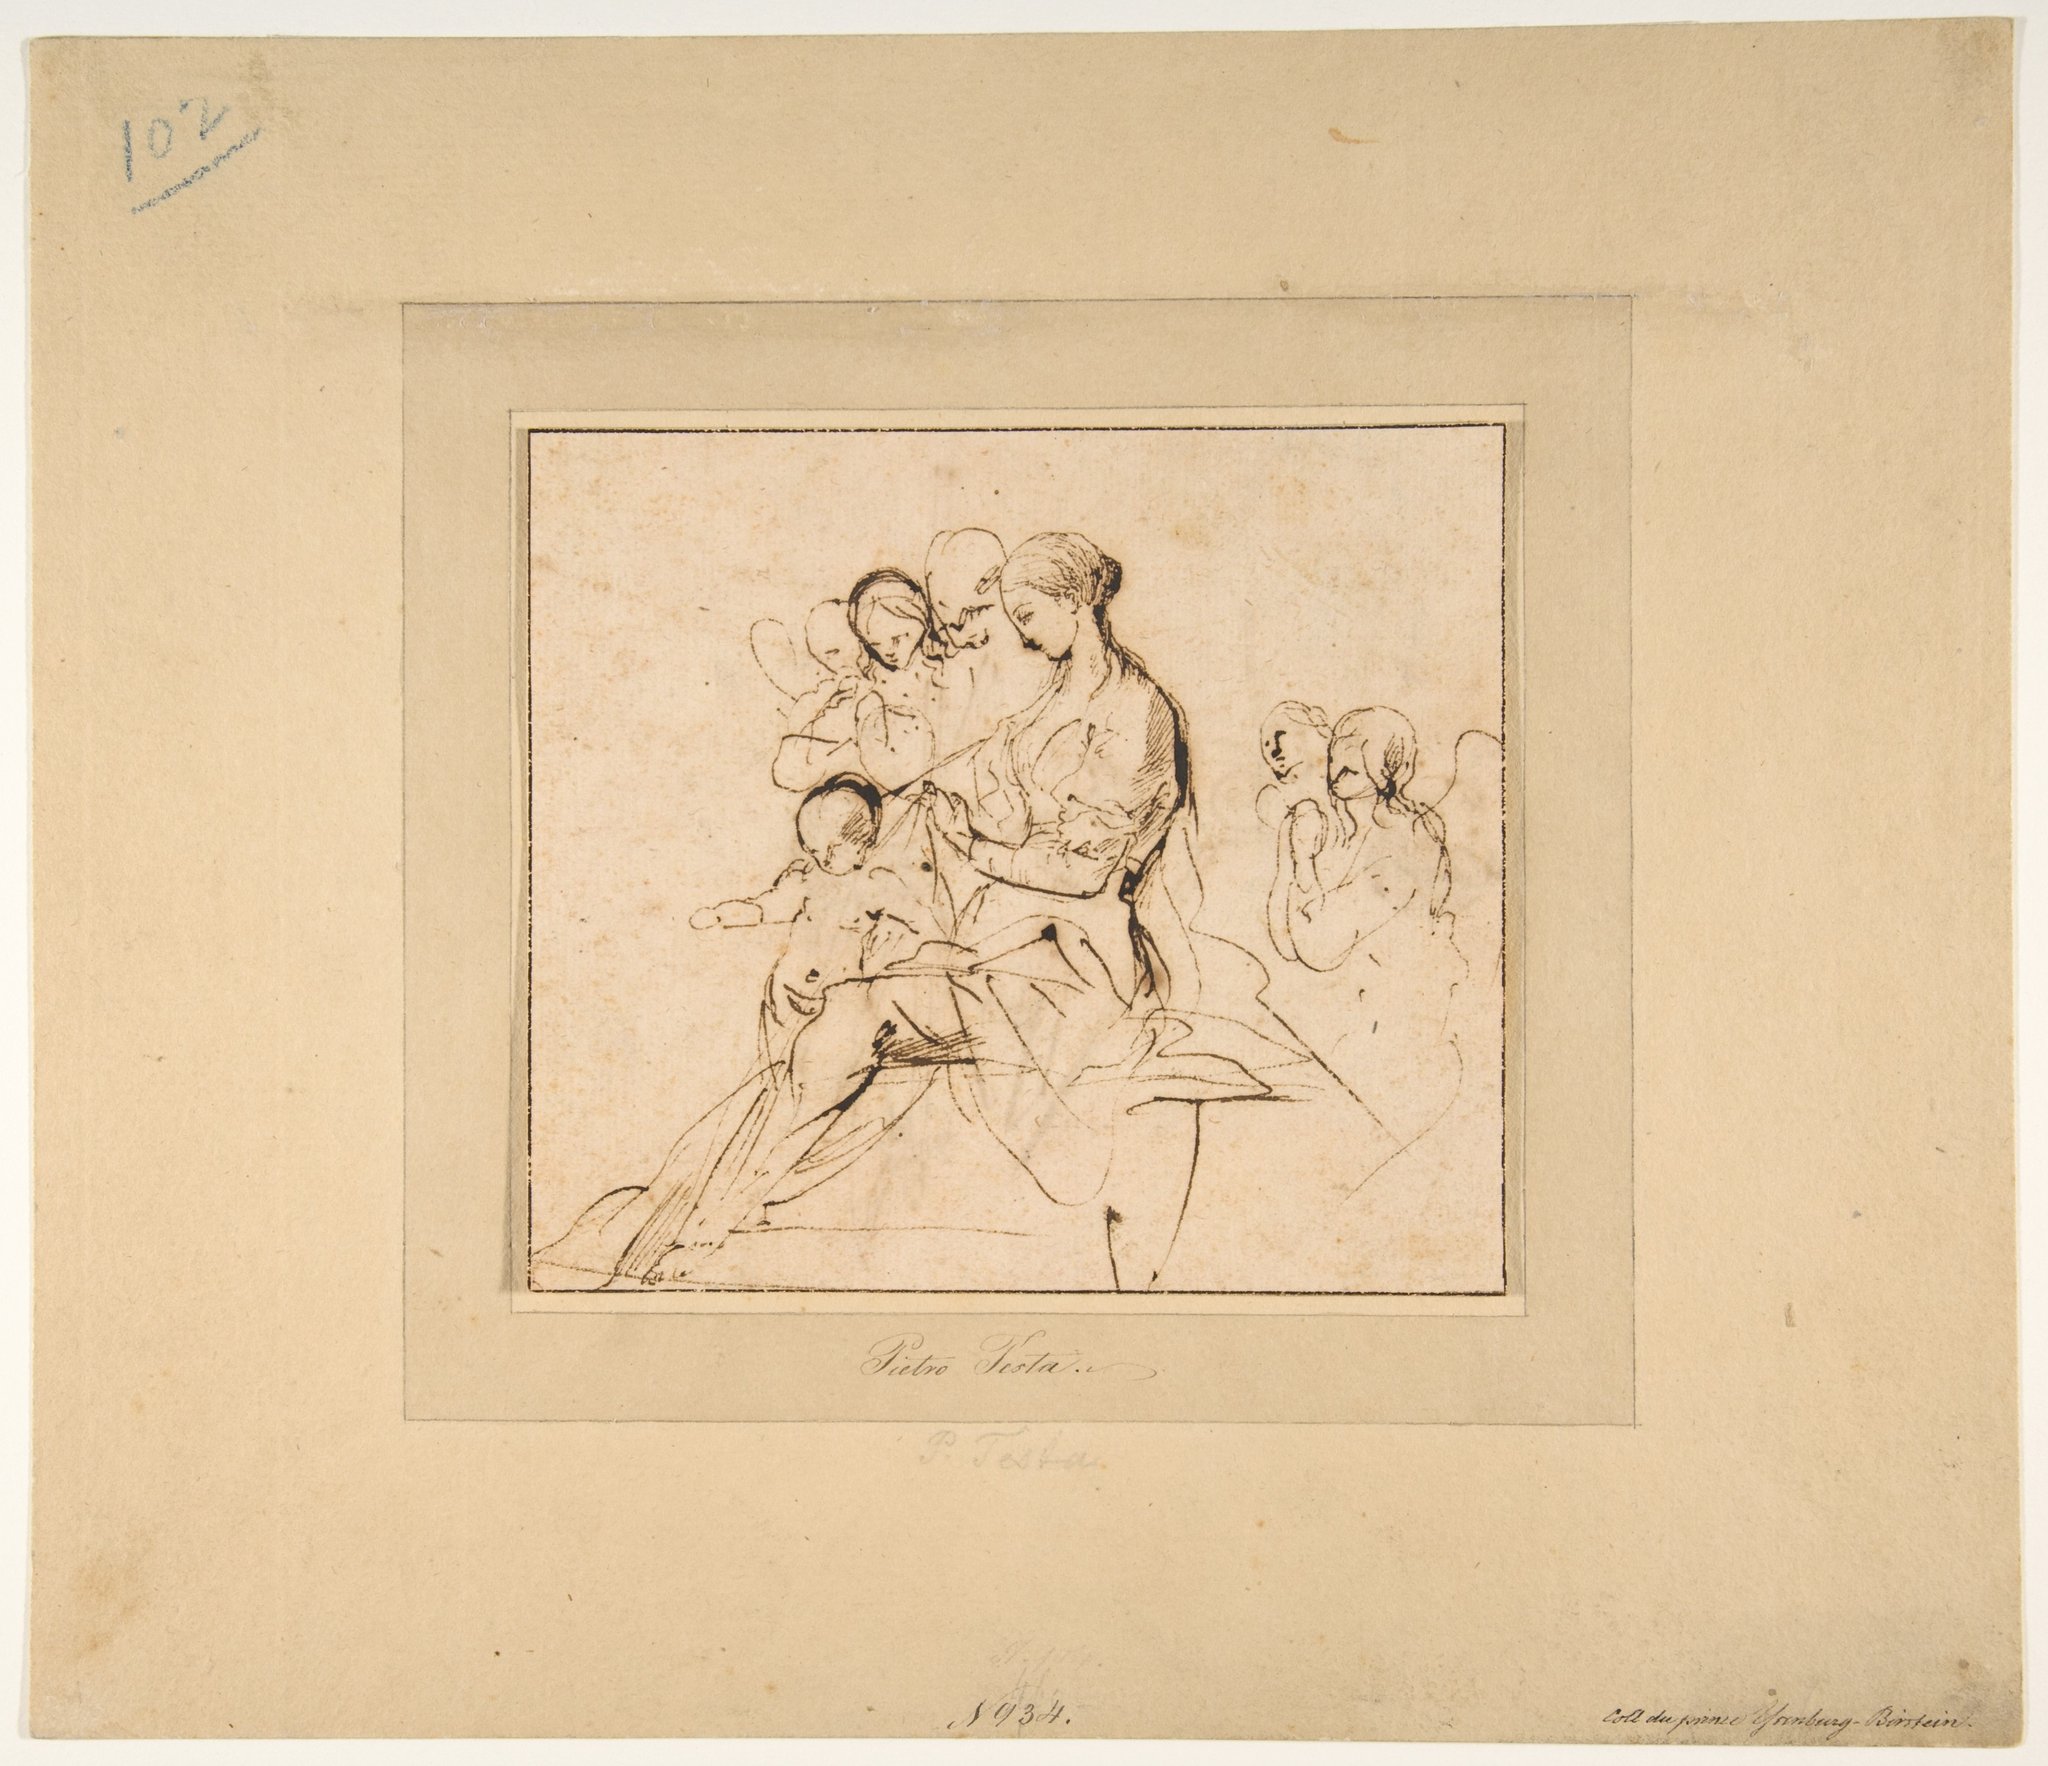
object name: drawing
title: The Holy Family with Attendant Angels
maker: pietro testa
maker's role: artist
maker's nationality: italian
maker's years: 1612-1650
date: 1612-1650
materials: ink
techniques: engraving, pen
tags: angels,holy family